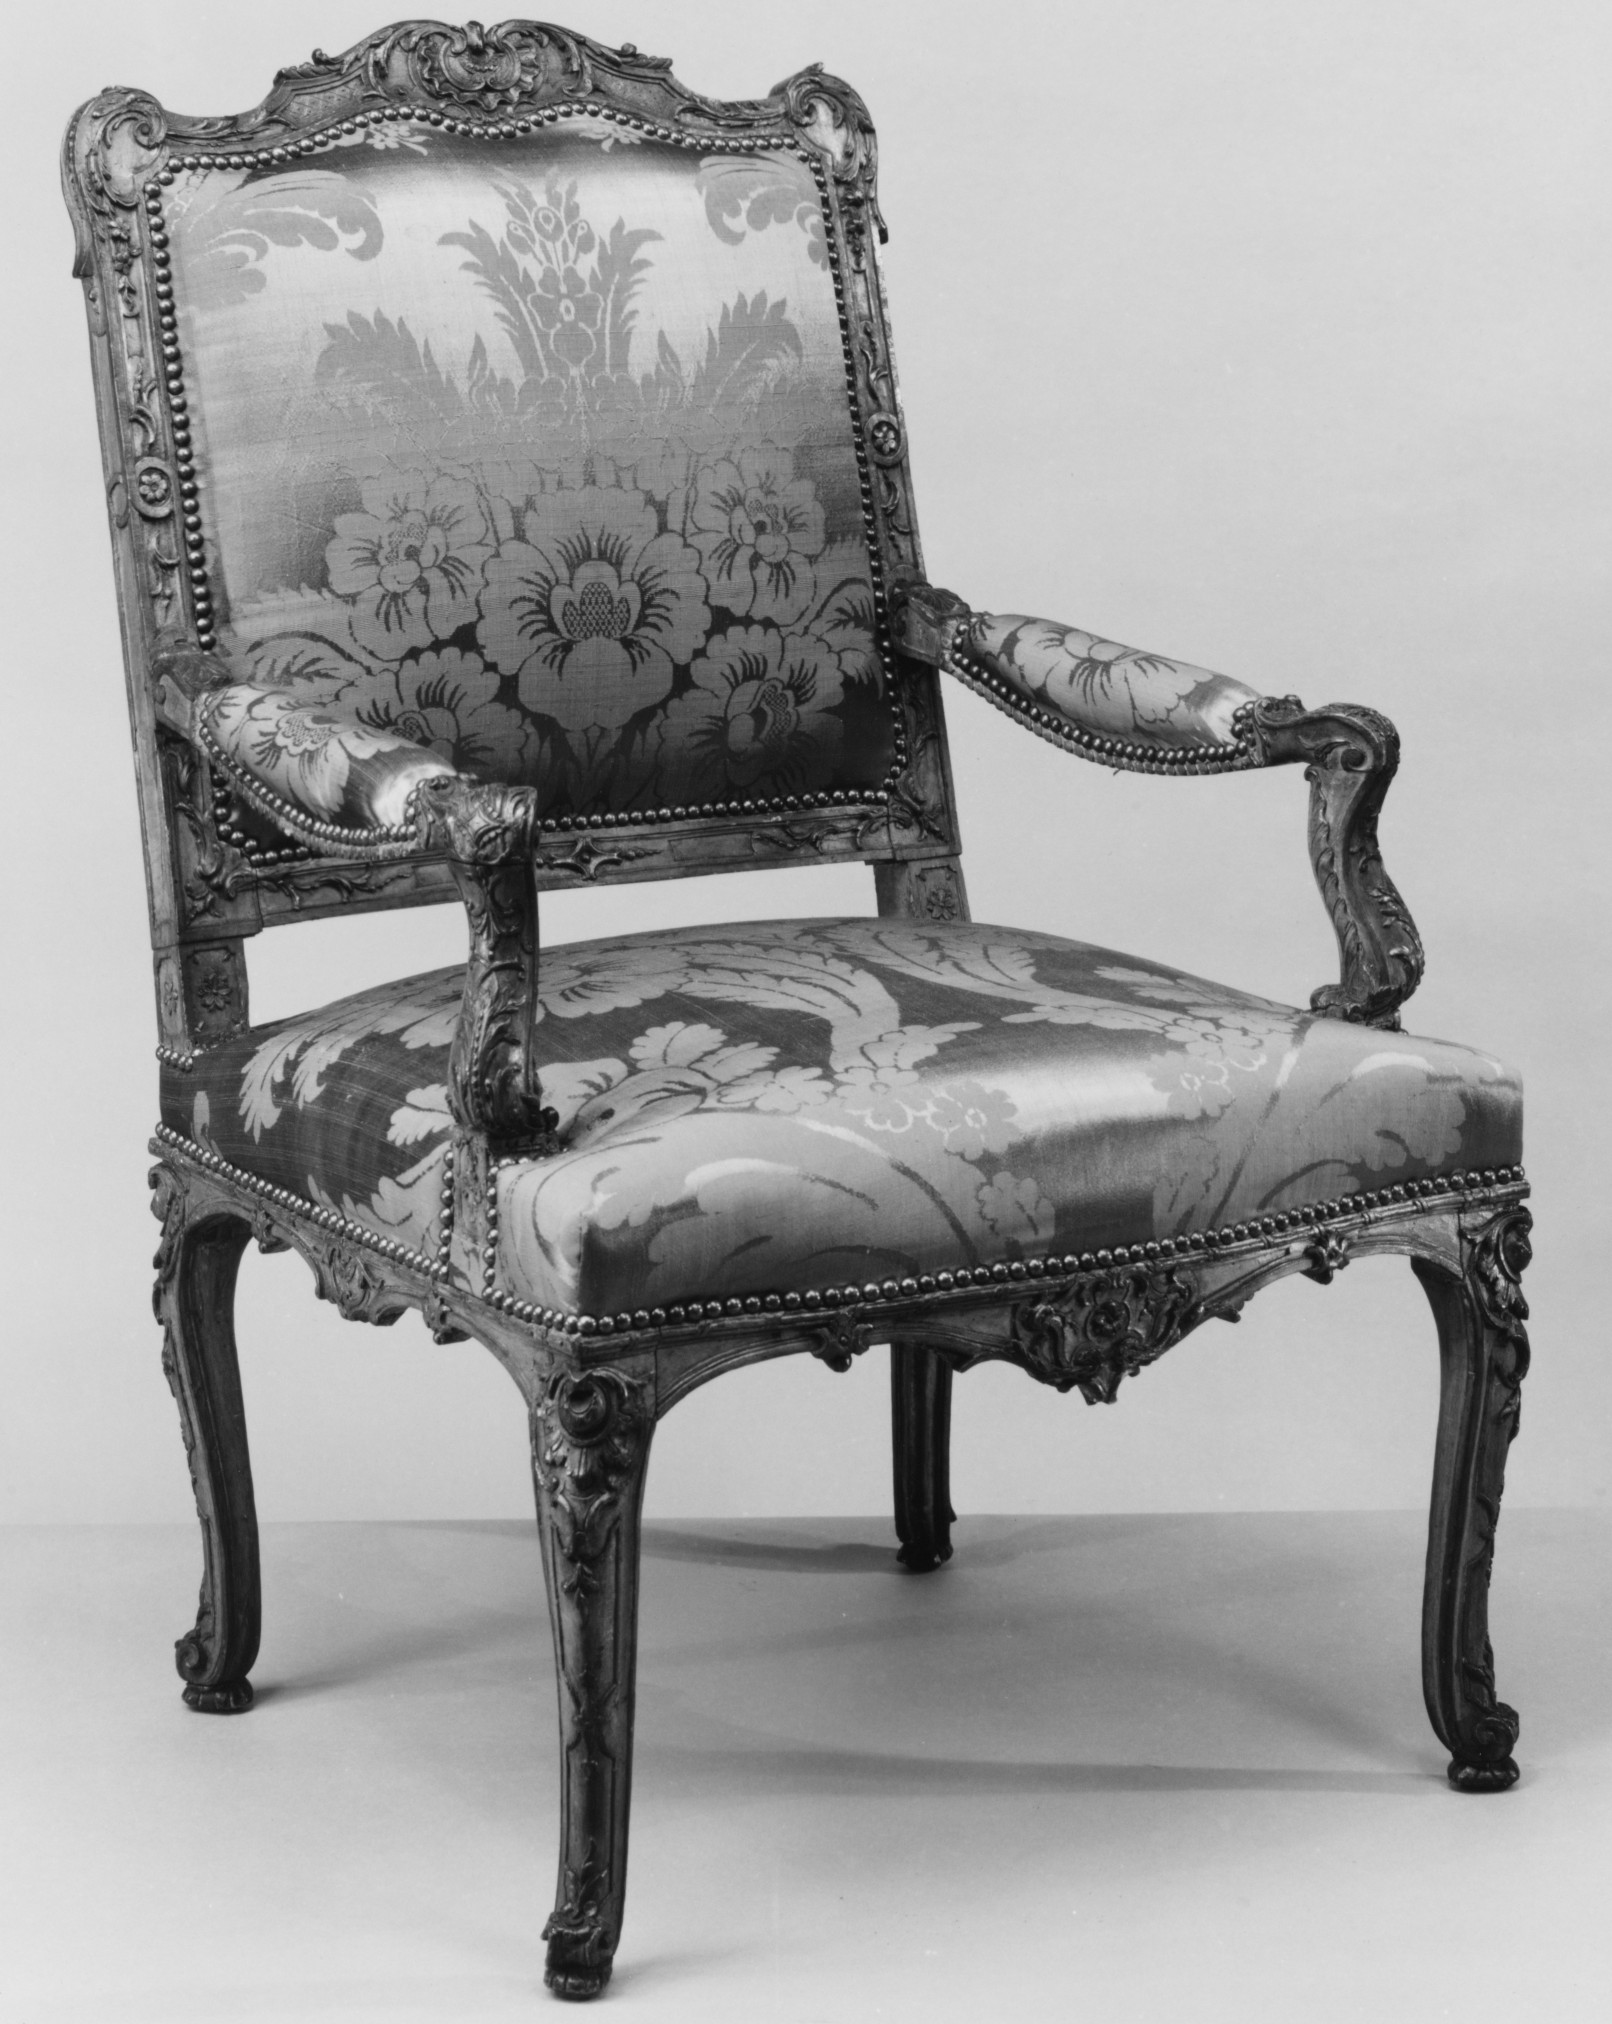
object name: armchair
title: Armchair (part of a set)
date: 1701-1725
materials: wood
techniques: carving, damask